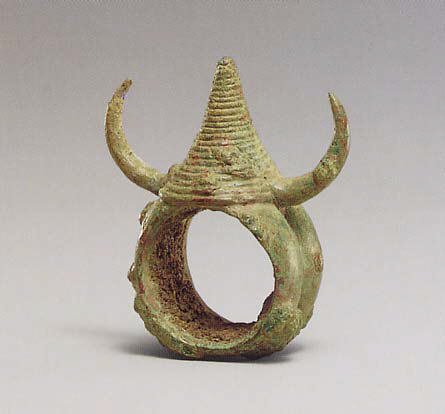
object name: ring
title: Ring with Horns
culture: thai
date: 300 BCE-200 CE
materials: bronze